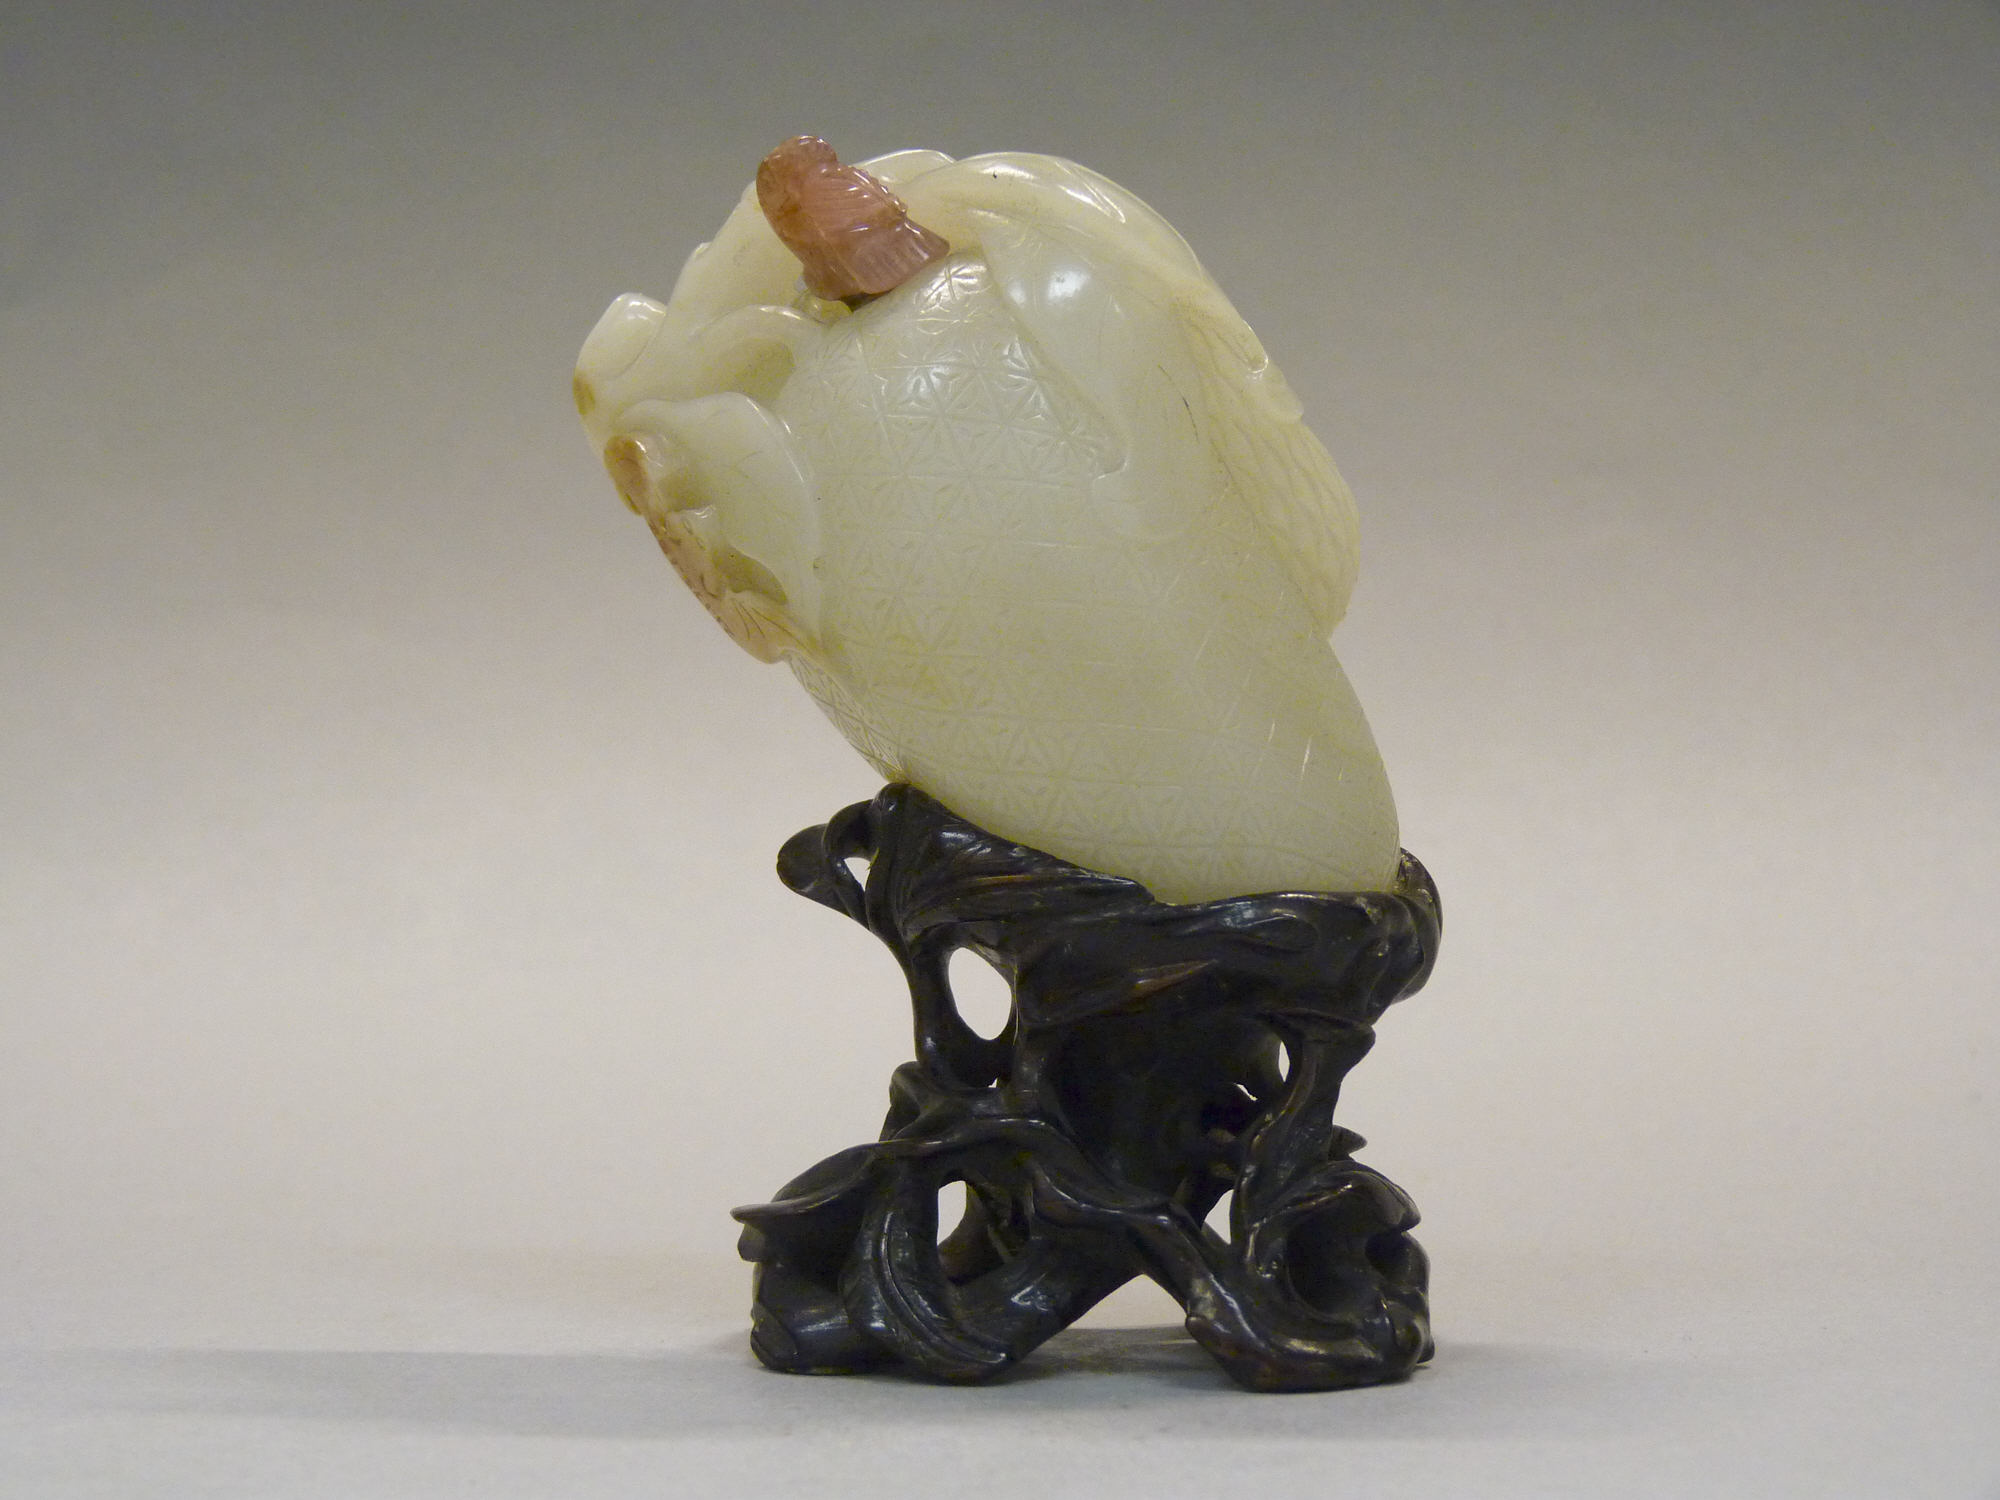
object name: snuff bottle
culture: chinese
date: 1736-1795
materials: jade, quartz